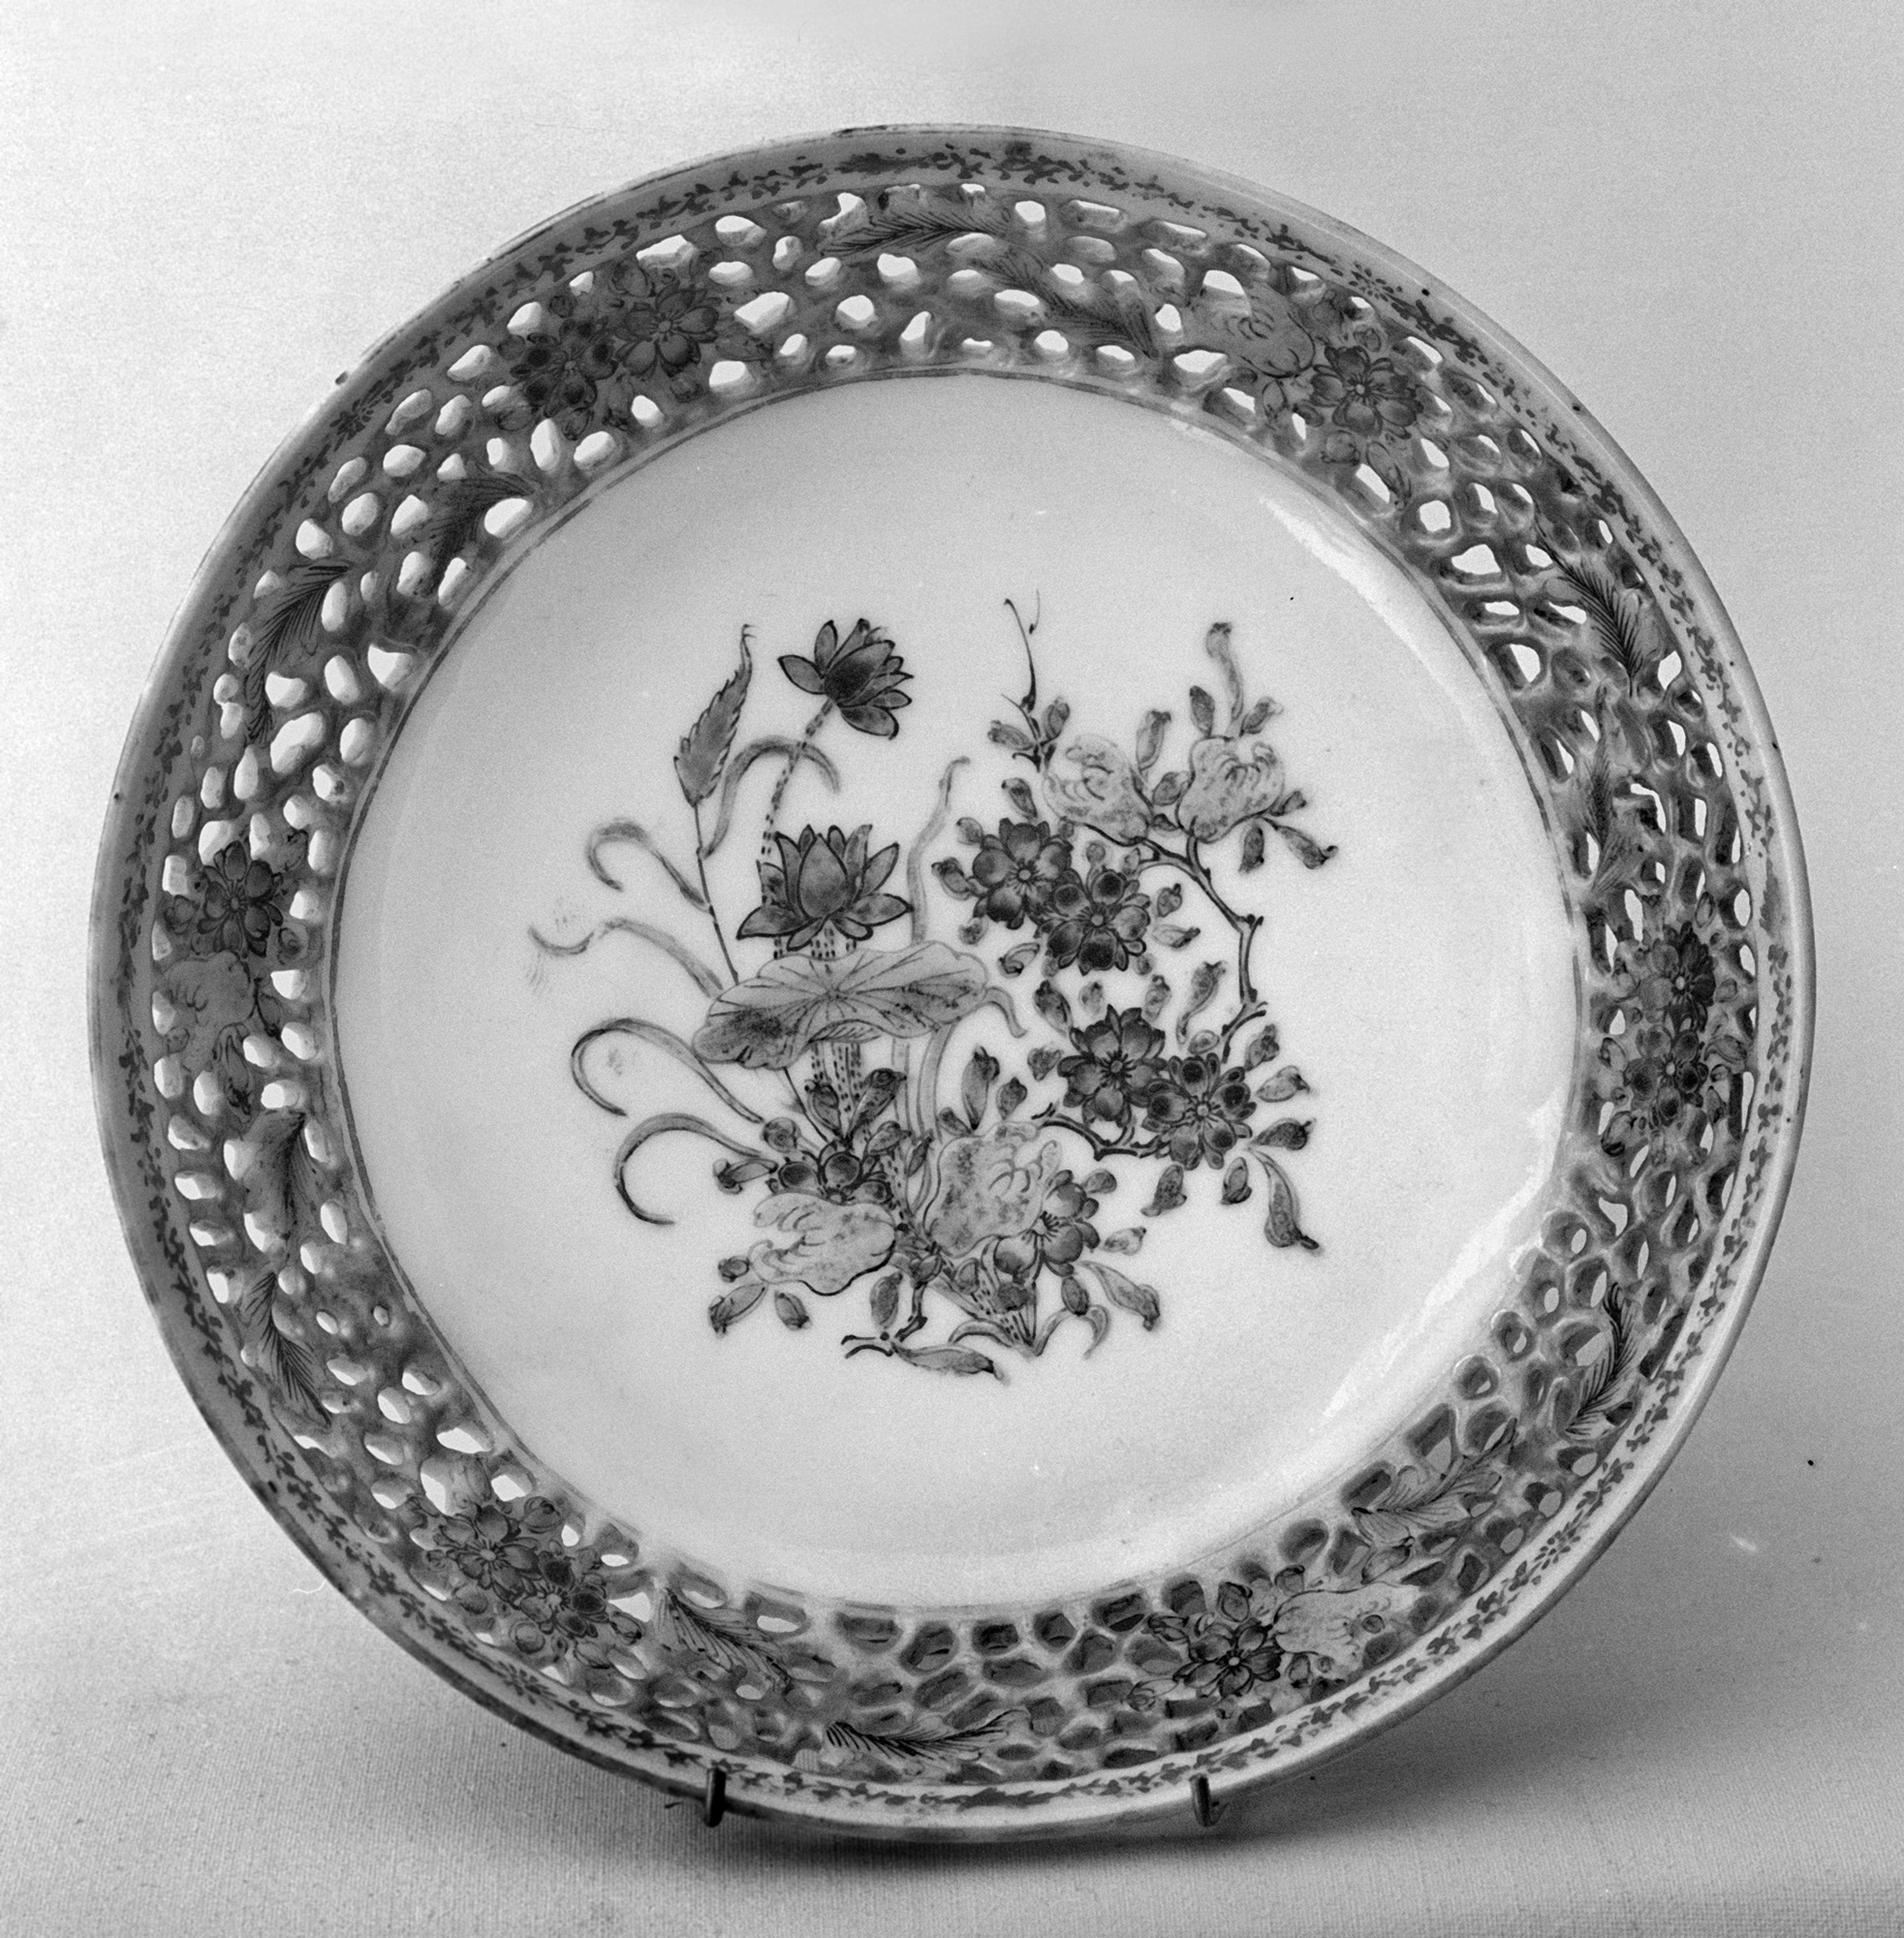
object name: saucer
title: Saucer with floral patterns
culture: chinese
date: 1767-1800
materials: enamel, porcelain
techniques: overglaze, painting, polychrome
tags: flowers